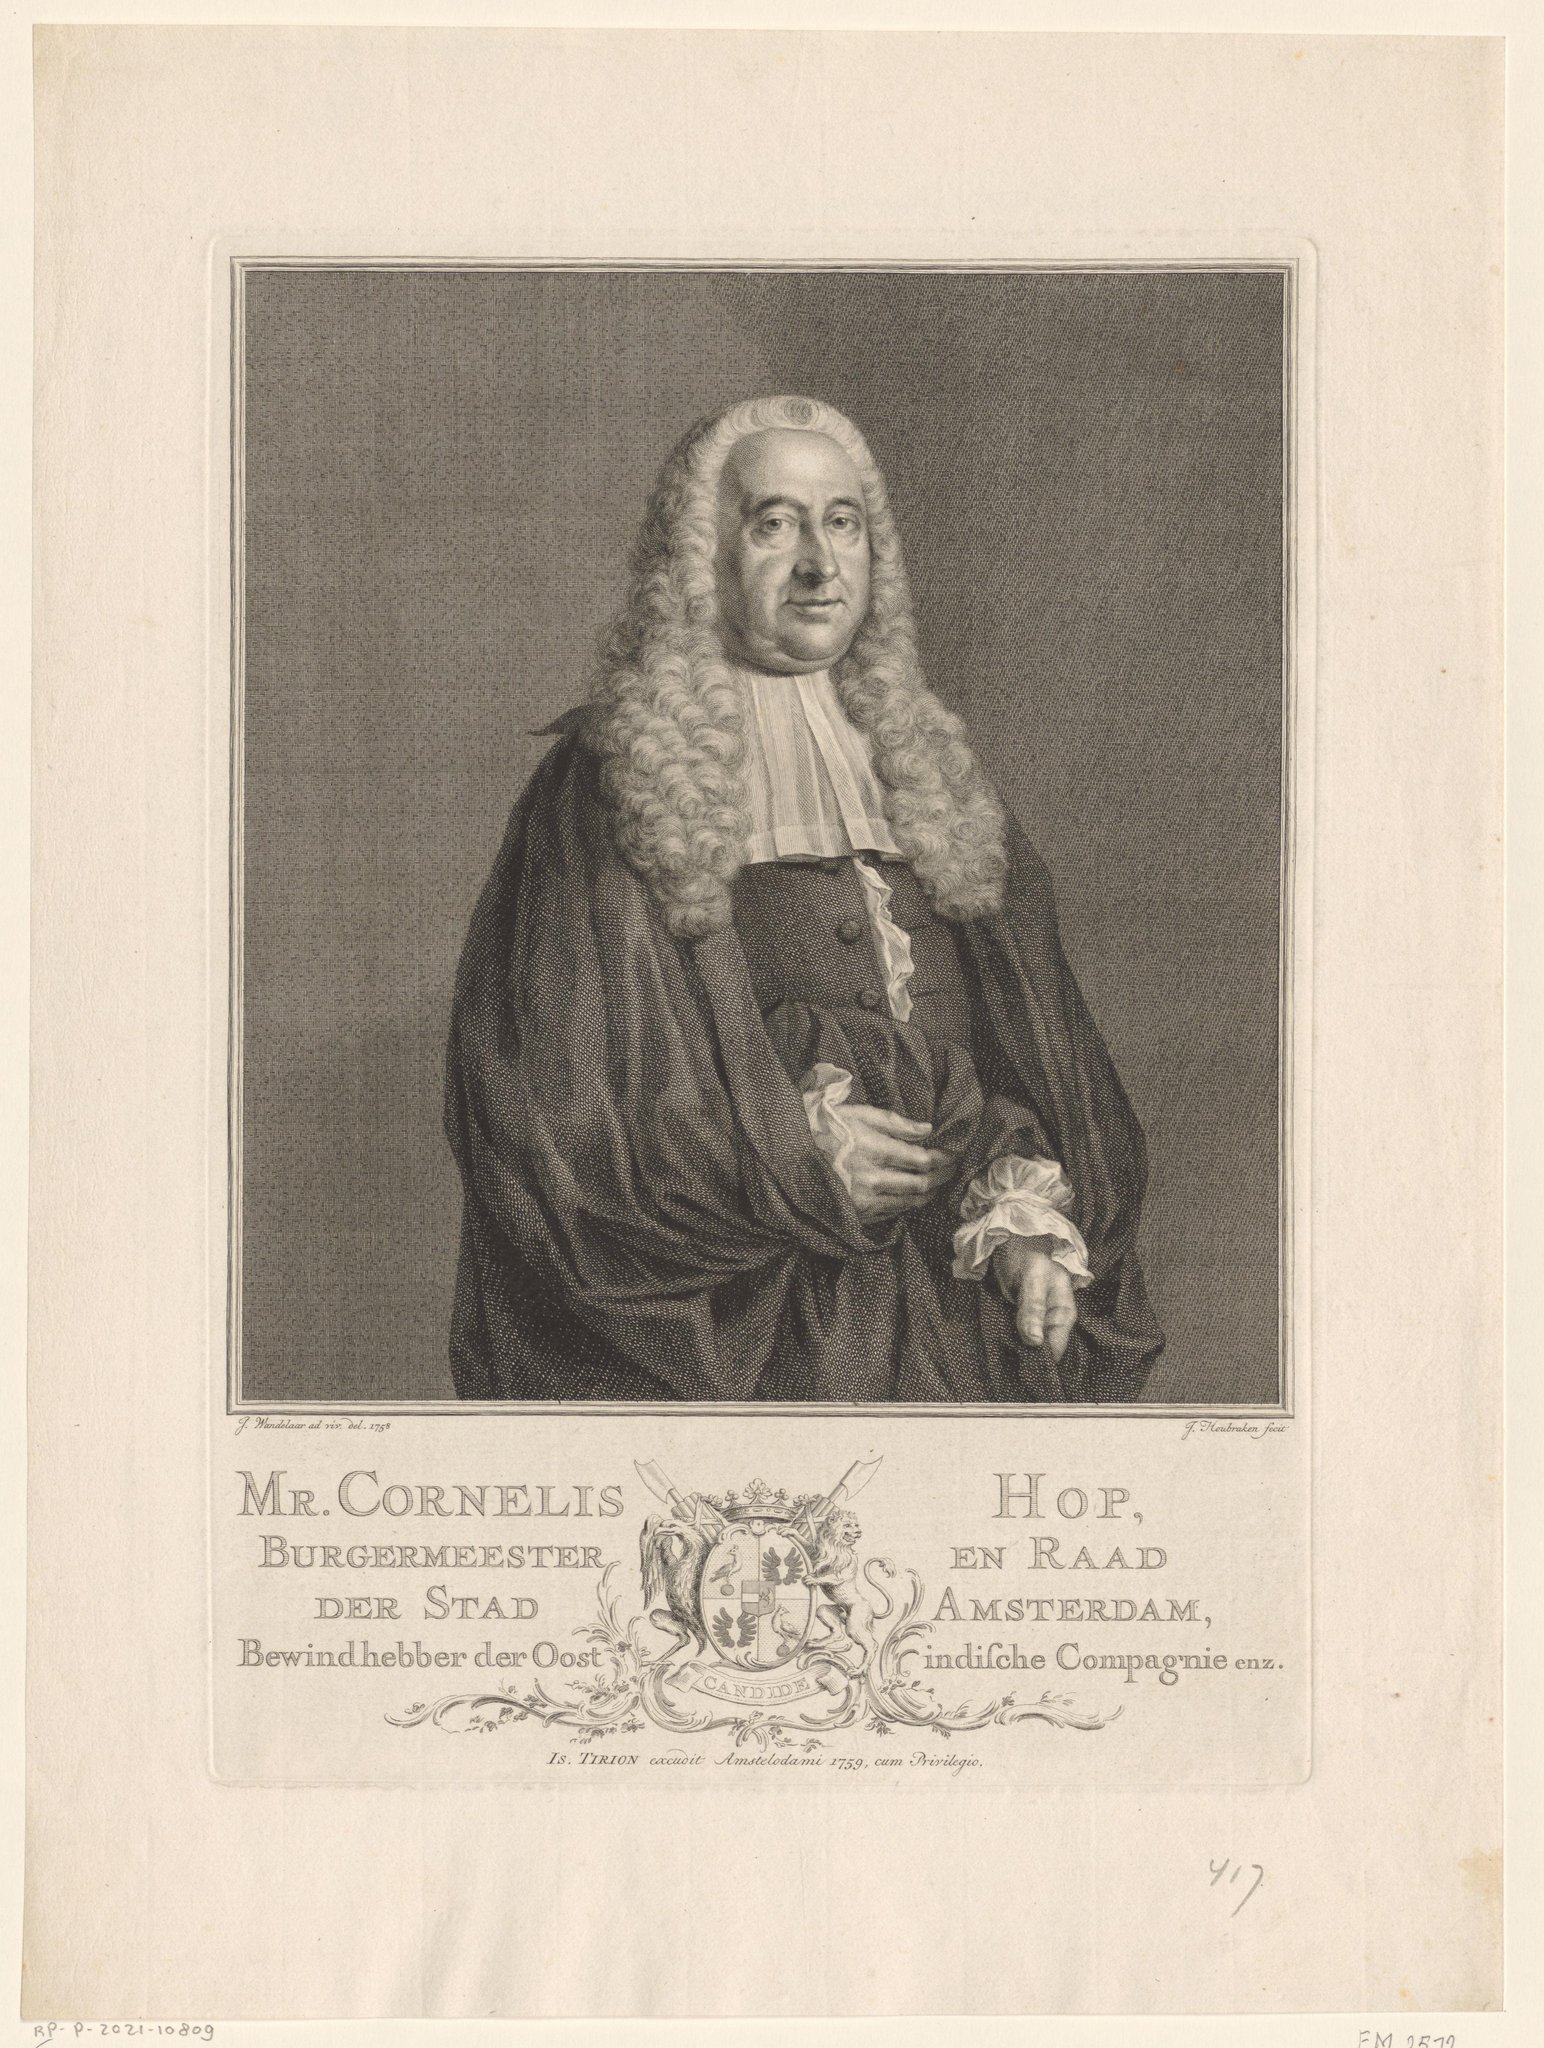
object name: print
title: Mr. Cornelis Hop, burgermeester en raad der stad Amsterdam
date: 1759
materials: paper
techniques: engraving, etching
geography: amsterdam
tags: mayor, burgomaster, historical persons, armorial bearing, heraldry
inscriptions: collector's mark: Lugt 2228